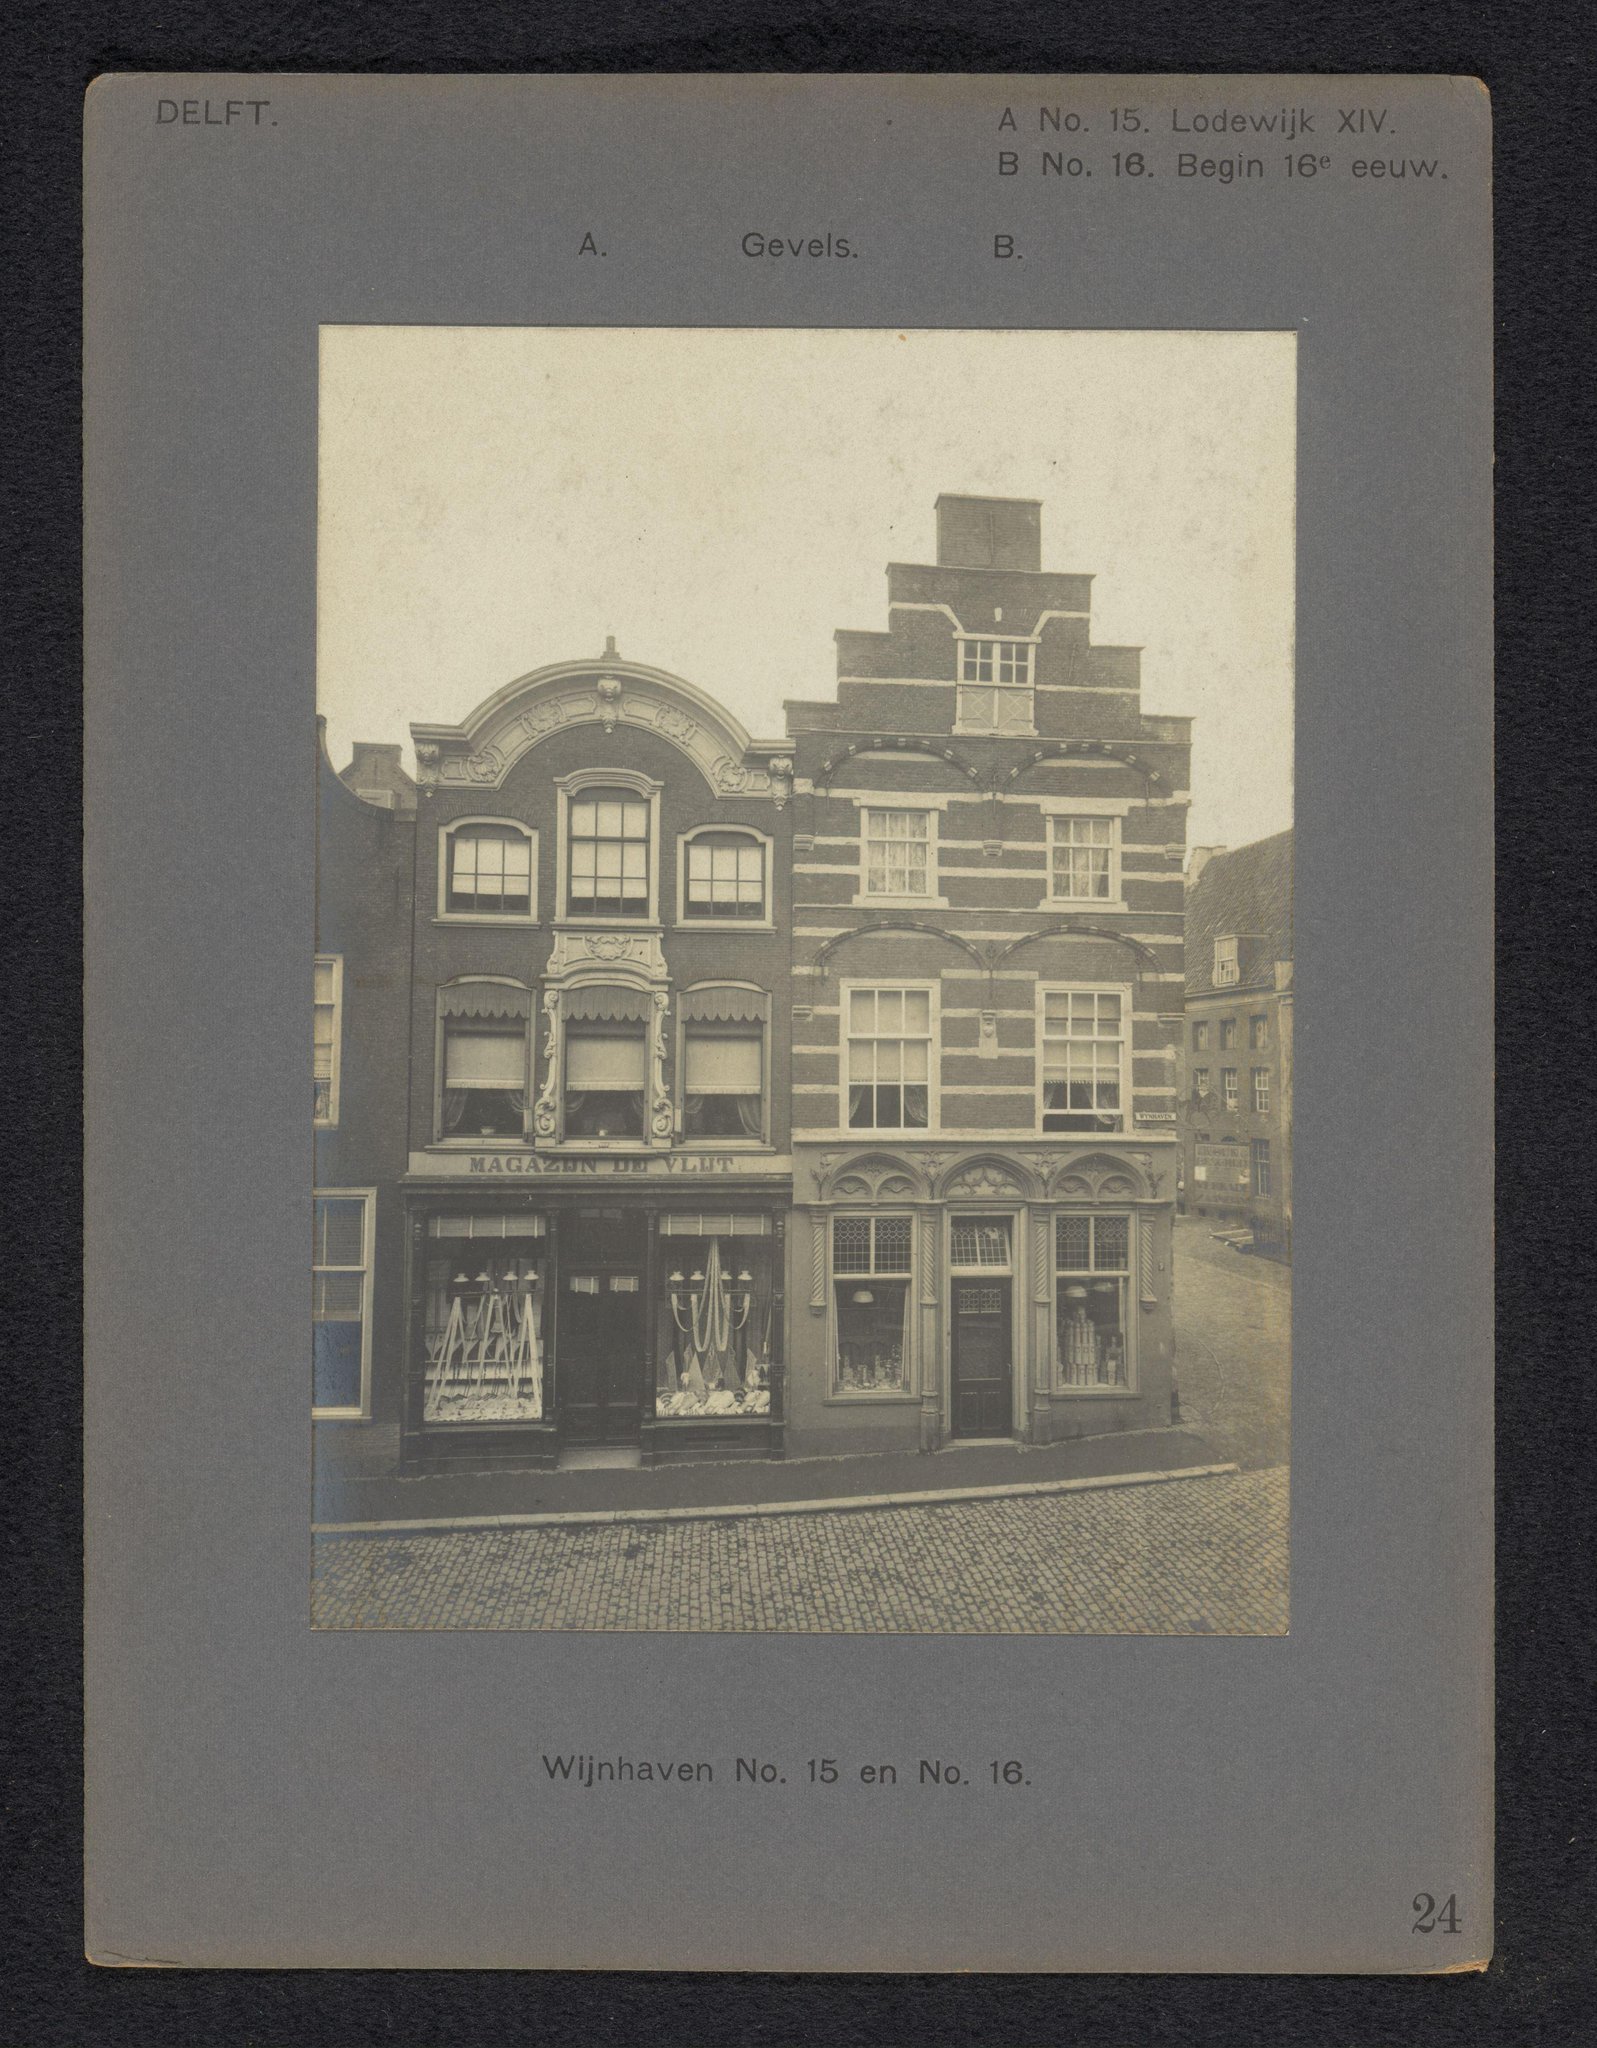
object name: photograph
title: Gezicht op twee huizen en winkels aan de Wijnhaven in Delft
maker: Anonymous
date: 1900-1904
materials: cardboard, photographic support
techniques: gelatin silver print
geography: delft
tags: shop-window, show-window, delft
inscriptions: number: ‘24’, inscription: ‘Delft. A No. 15. Lodwijk XIV. B No. 16. Begin 16e eeuw’, inscription: ‘Het recht van reproductie dezer photo's wordt door den Uitgever voorbehouden.’